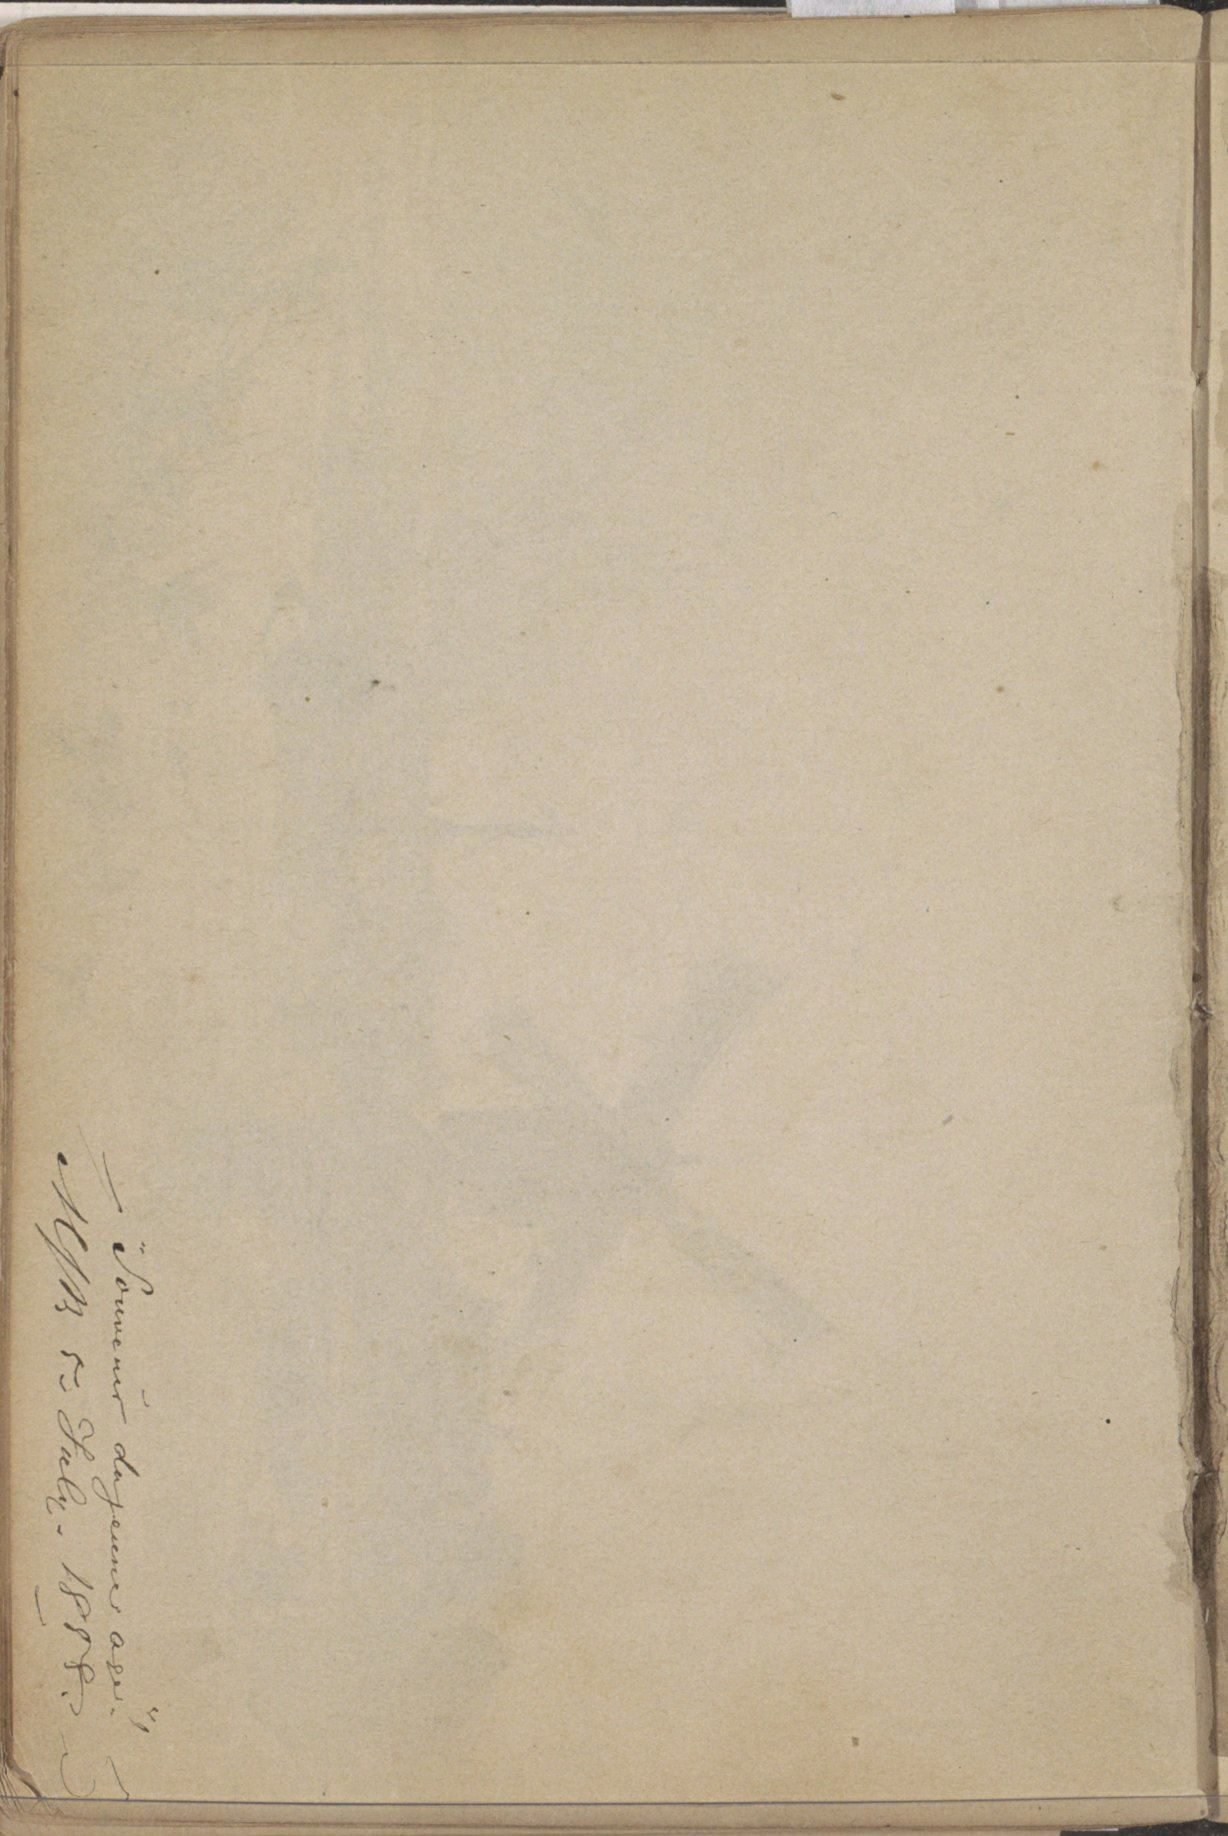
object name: sketchbook leaf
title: Notitie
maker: johannes tavenraat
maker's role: draughtsman, painter, print maker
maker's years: 1809-1881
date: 1807-1858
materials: ink, paper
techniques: pen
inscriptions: date and inscription: ‘"Souvenir dejeunes age."/ MB 5. July. 1858.’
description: Blad 39 verso uit een schetsboek met 44 bladen.